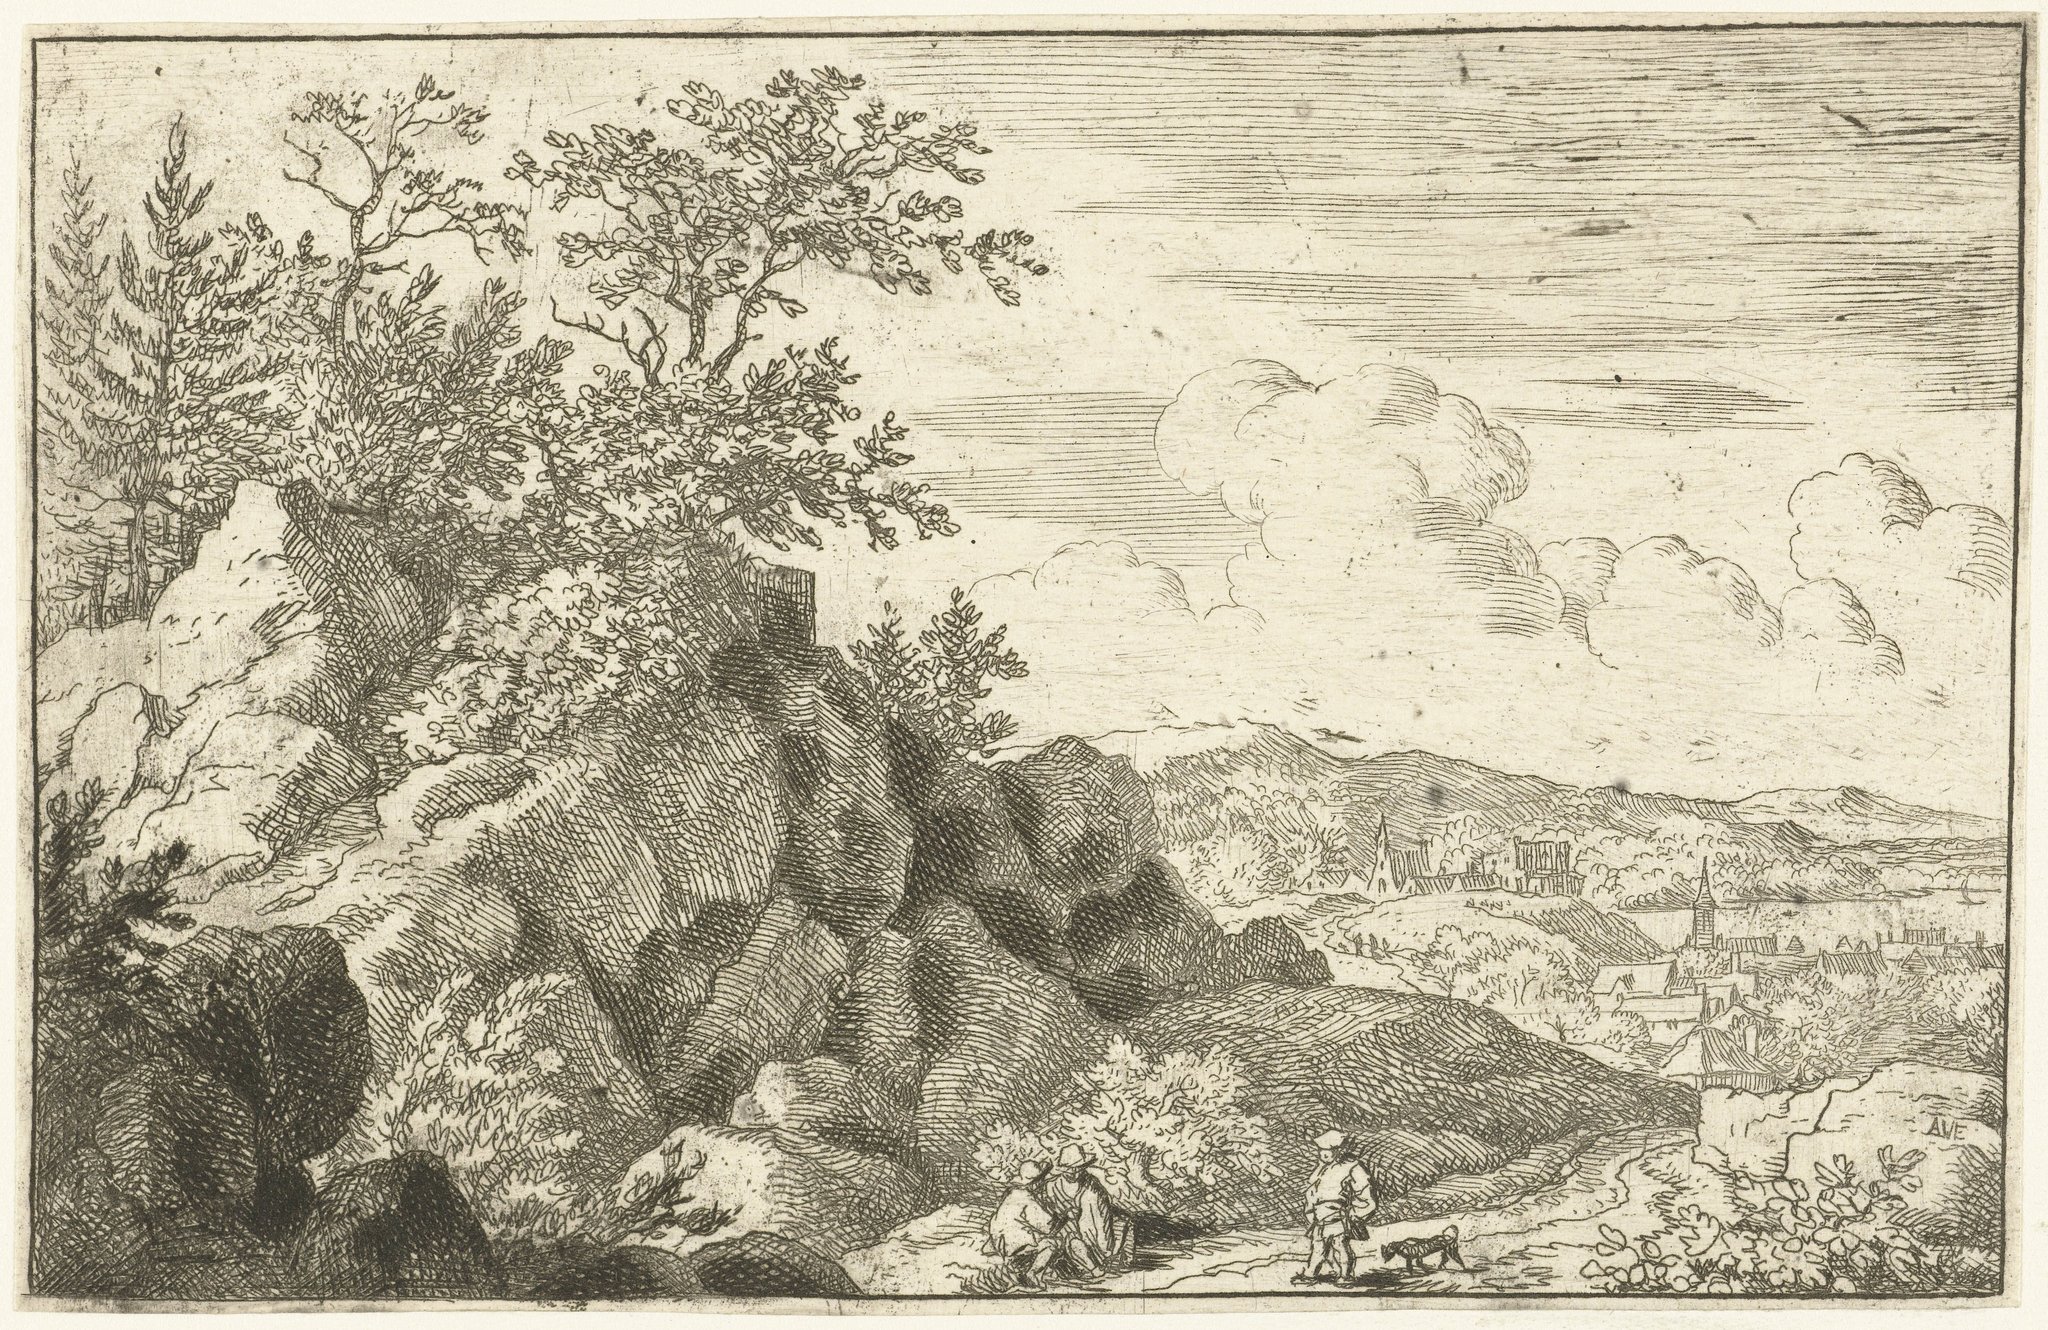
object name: print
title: Berglandschap met man en hond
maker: allaert van everdingen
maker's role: draughtsman, painter, print maker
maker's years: 1621-1675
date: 1631-1675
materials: paper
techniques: etching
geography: netherlands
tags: dog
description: Berglandschap met op de voorgrond twee personen zittend langs een pad. Op het pad een man en een hond.